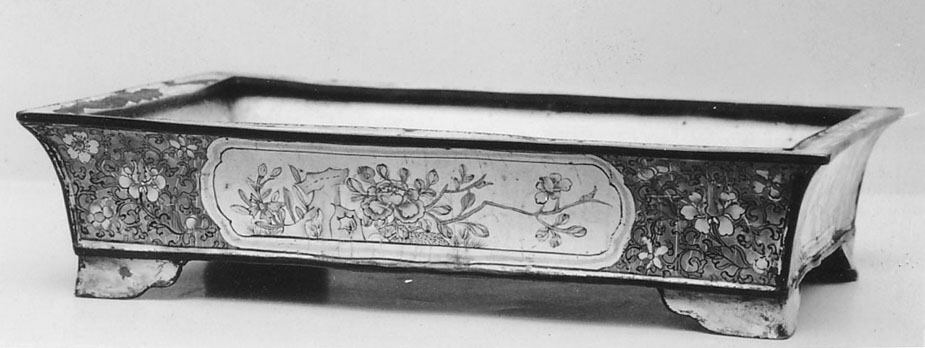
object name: jardinière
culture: chinese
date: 1736-1795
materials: enamel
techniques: painting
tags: flowers